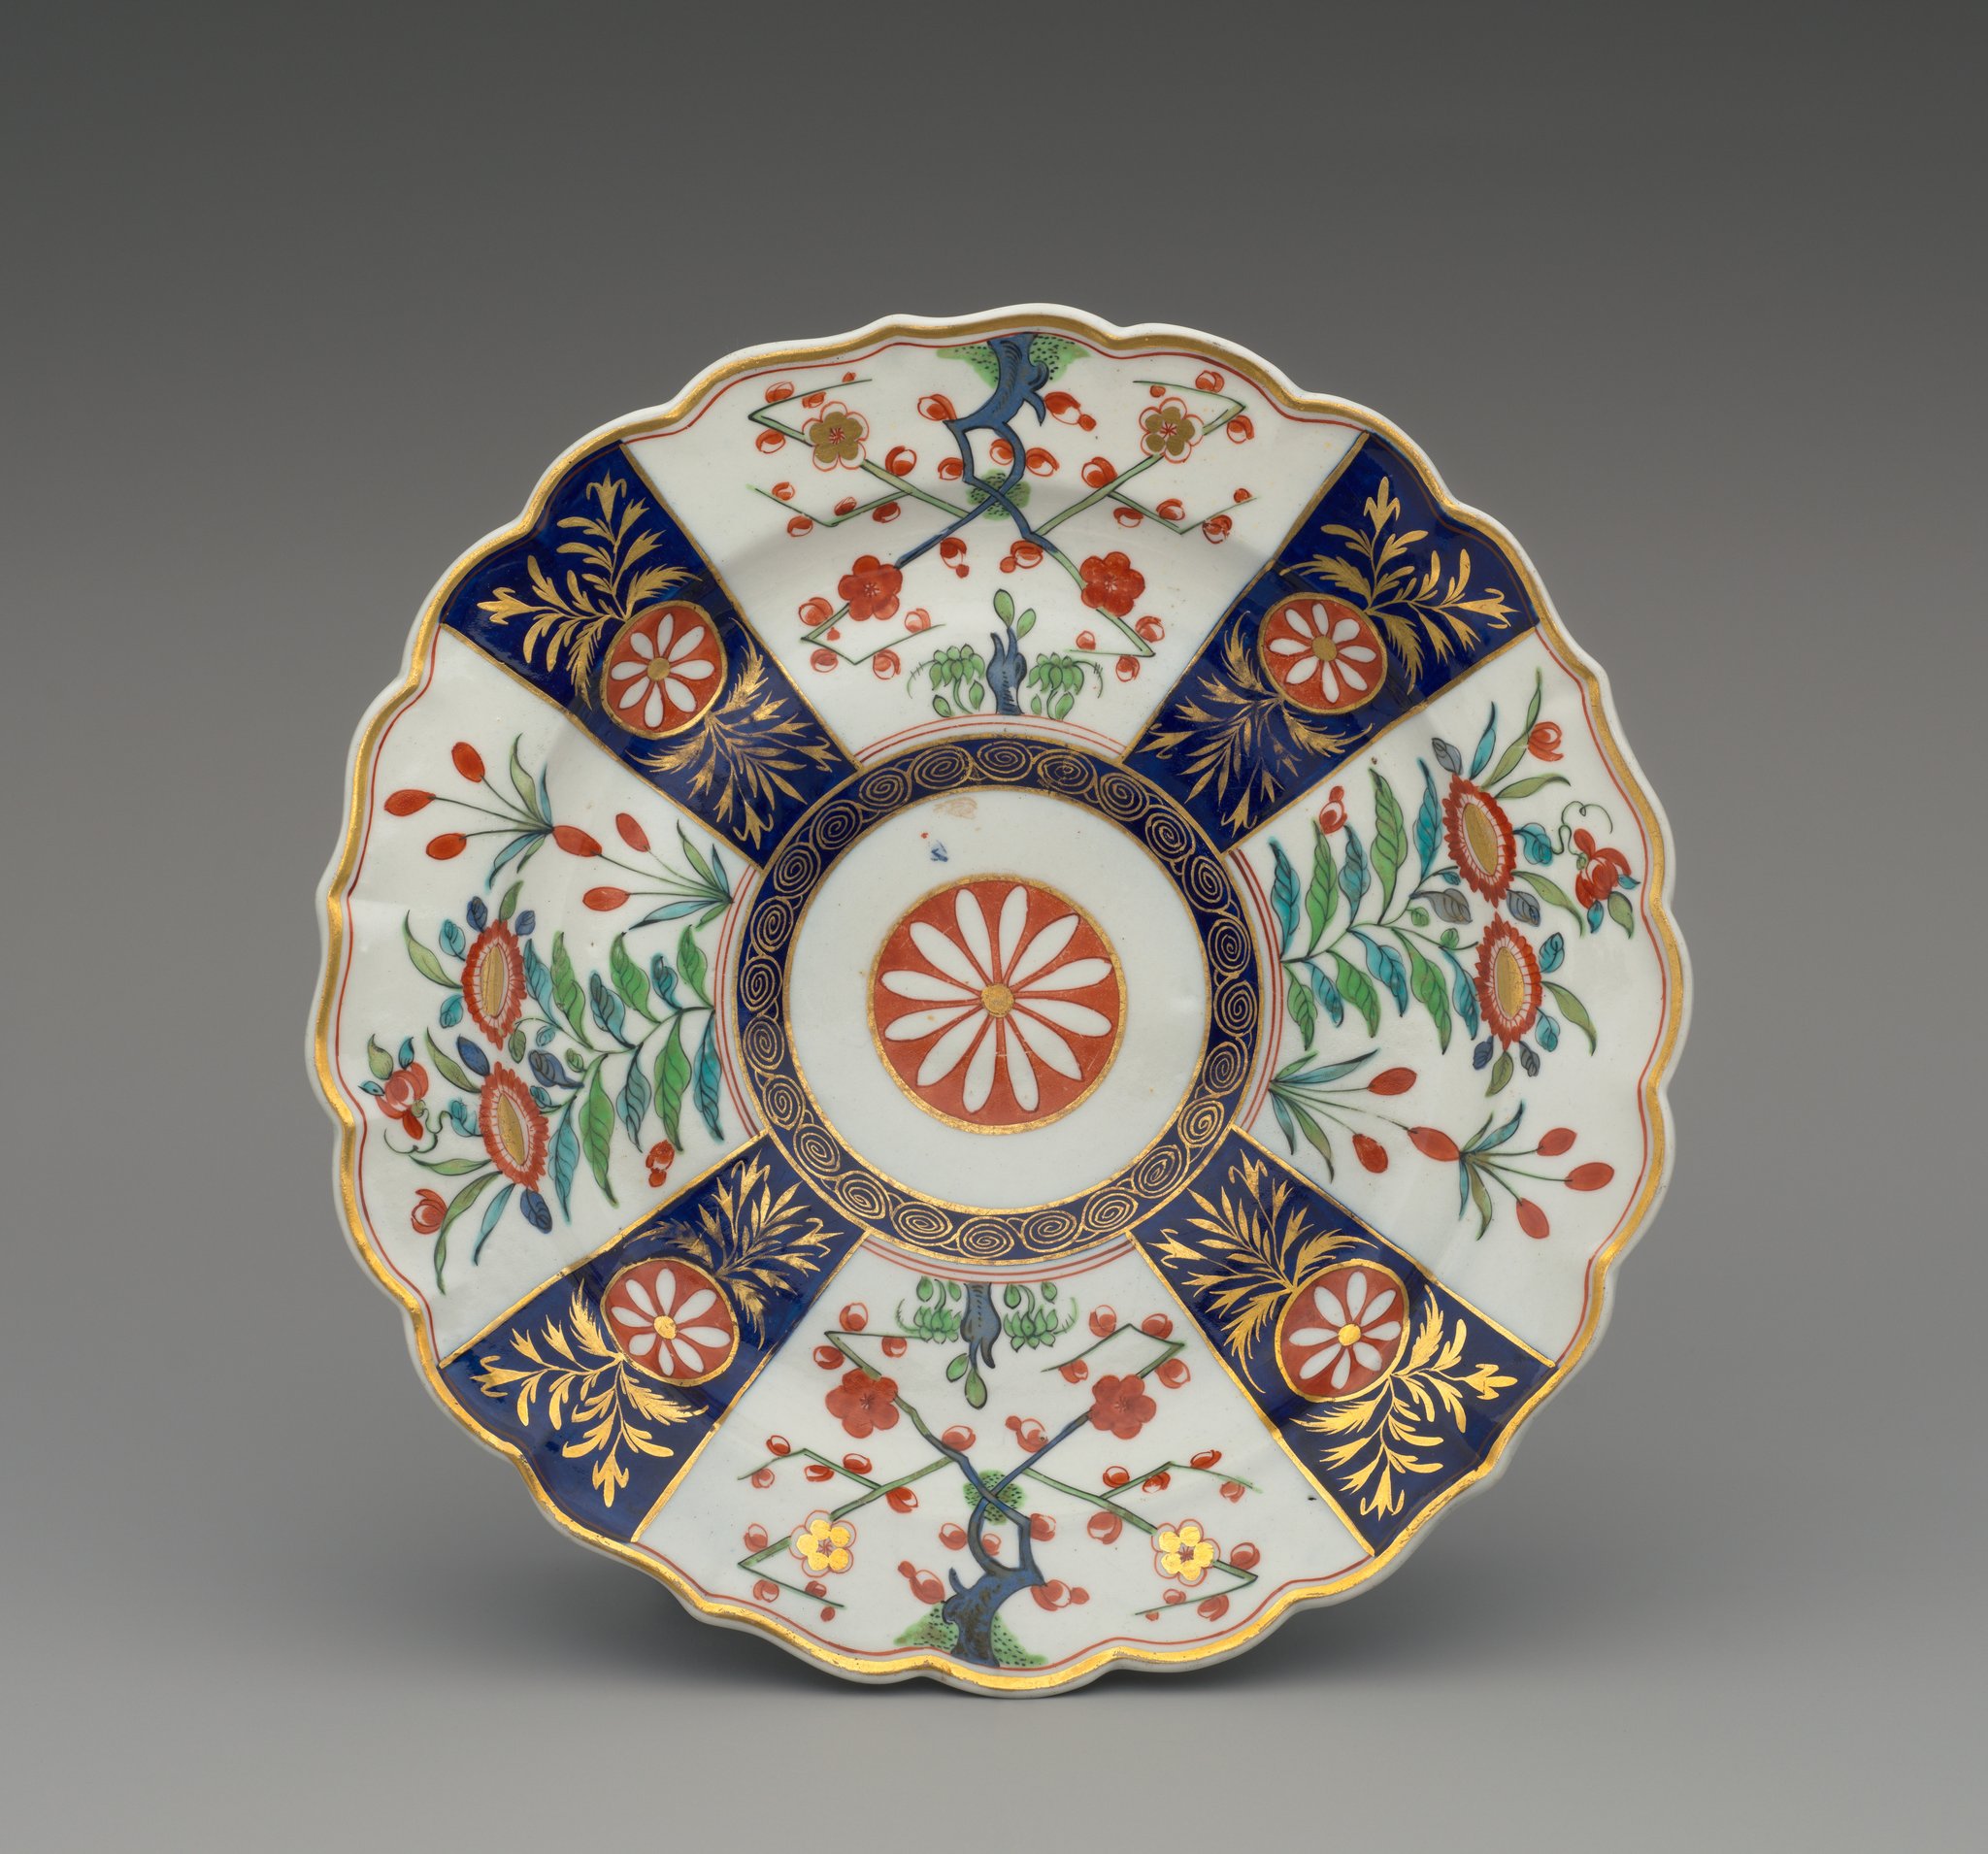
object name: plate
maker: worcester factory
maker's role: factory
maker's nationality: british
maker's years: 1751-2008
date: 1770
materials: soft paste porcelain